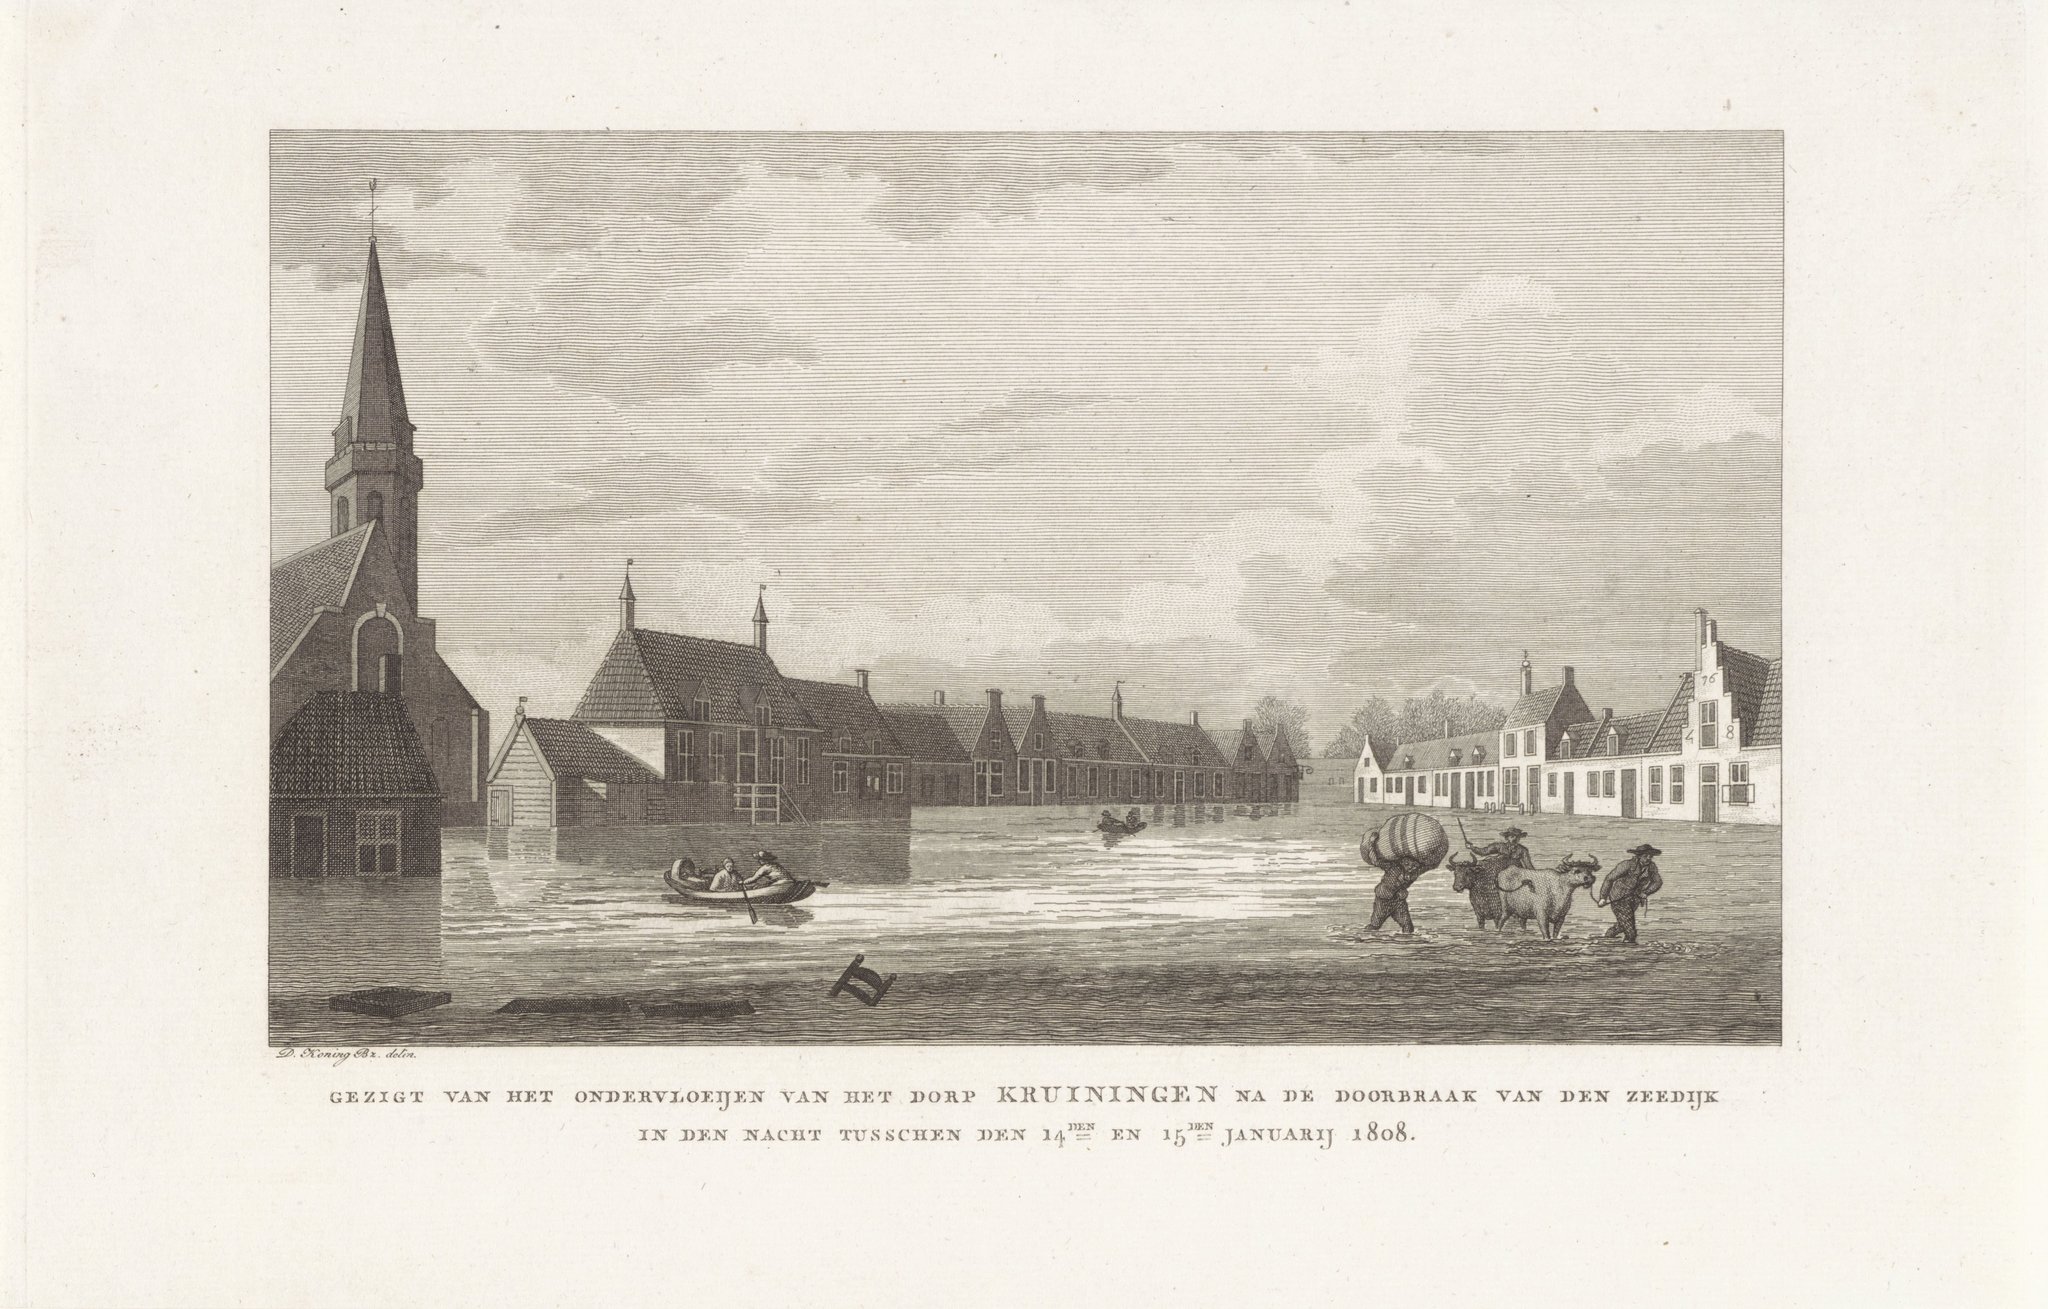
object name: print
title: Gezigt van het ondervloeijen van het dorp Kruiningen na de doorbraak van den Zeedijk in den nacht tusschen den 14den en 15den januarij 1808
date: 1808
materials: paper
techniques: etching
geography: haarlem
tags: flood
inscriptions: collector's mark: Lugt Lugt 2228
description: Prent gebruikt in: Hoek, S. van. Natuur- en geschiedkundige beschrijving van den verschrikkelijken watervloed tusschen den XIVden en XVden van Louwmaand des jaars 1808. Haarlem: Adriaan Pietersz. Loosjes, 1808.